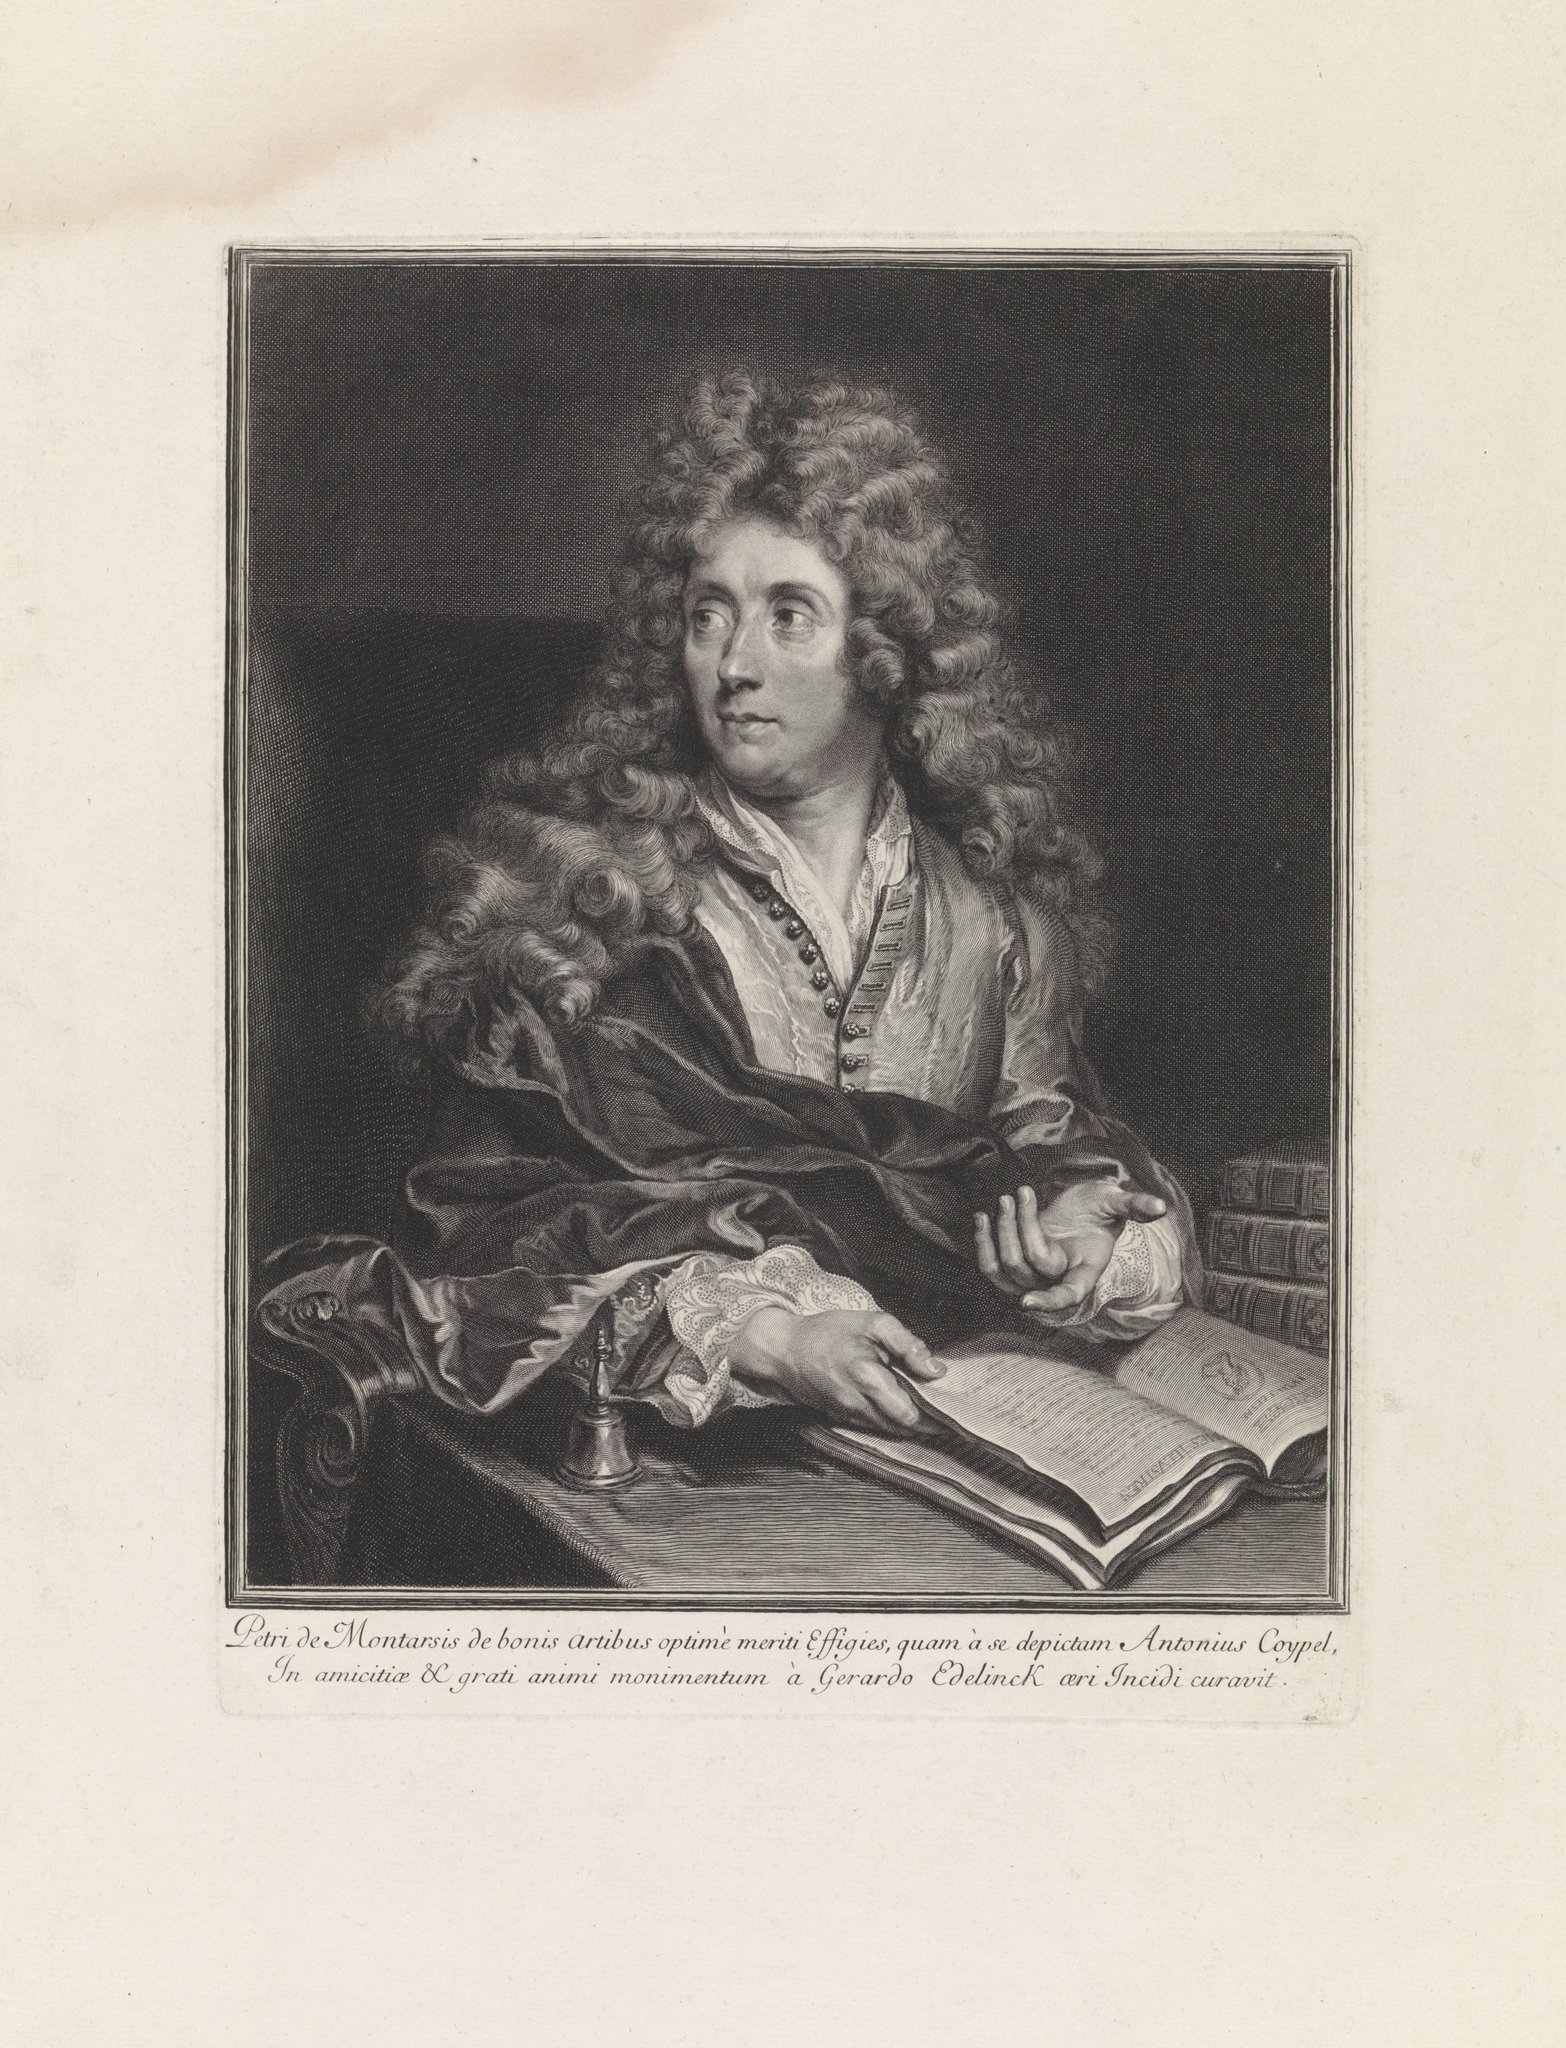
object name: print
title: Portret van Pierre de Montarsis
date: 1692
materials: paper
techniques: engraving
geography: paris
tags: pierre de montarsis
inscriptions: collector's mark: Lugt 2228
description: Portret van Pierre de Montarsis, ten halven lijve zittend achter een bureau afgebeeld. Hij kijkt opzij, terwijl hij met zijn rechter hand een opengeslagen boek vast heeft en met zijn linker hand een wijzend gebaar maakt. Onder de voorstelling twee regels tekst in Latijn.